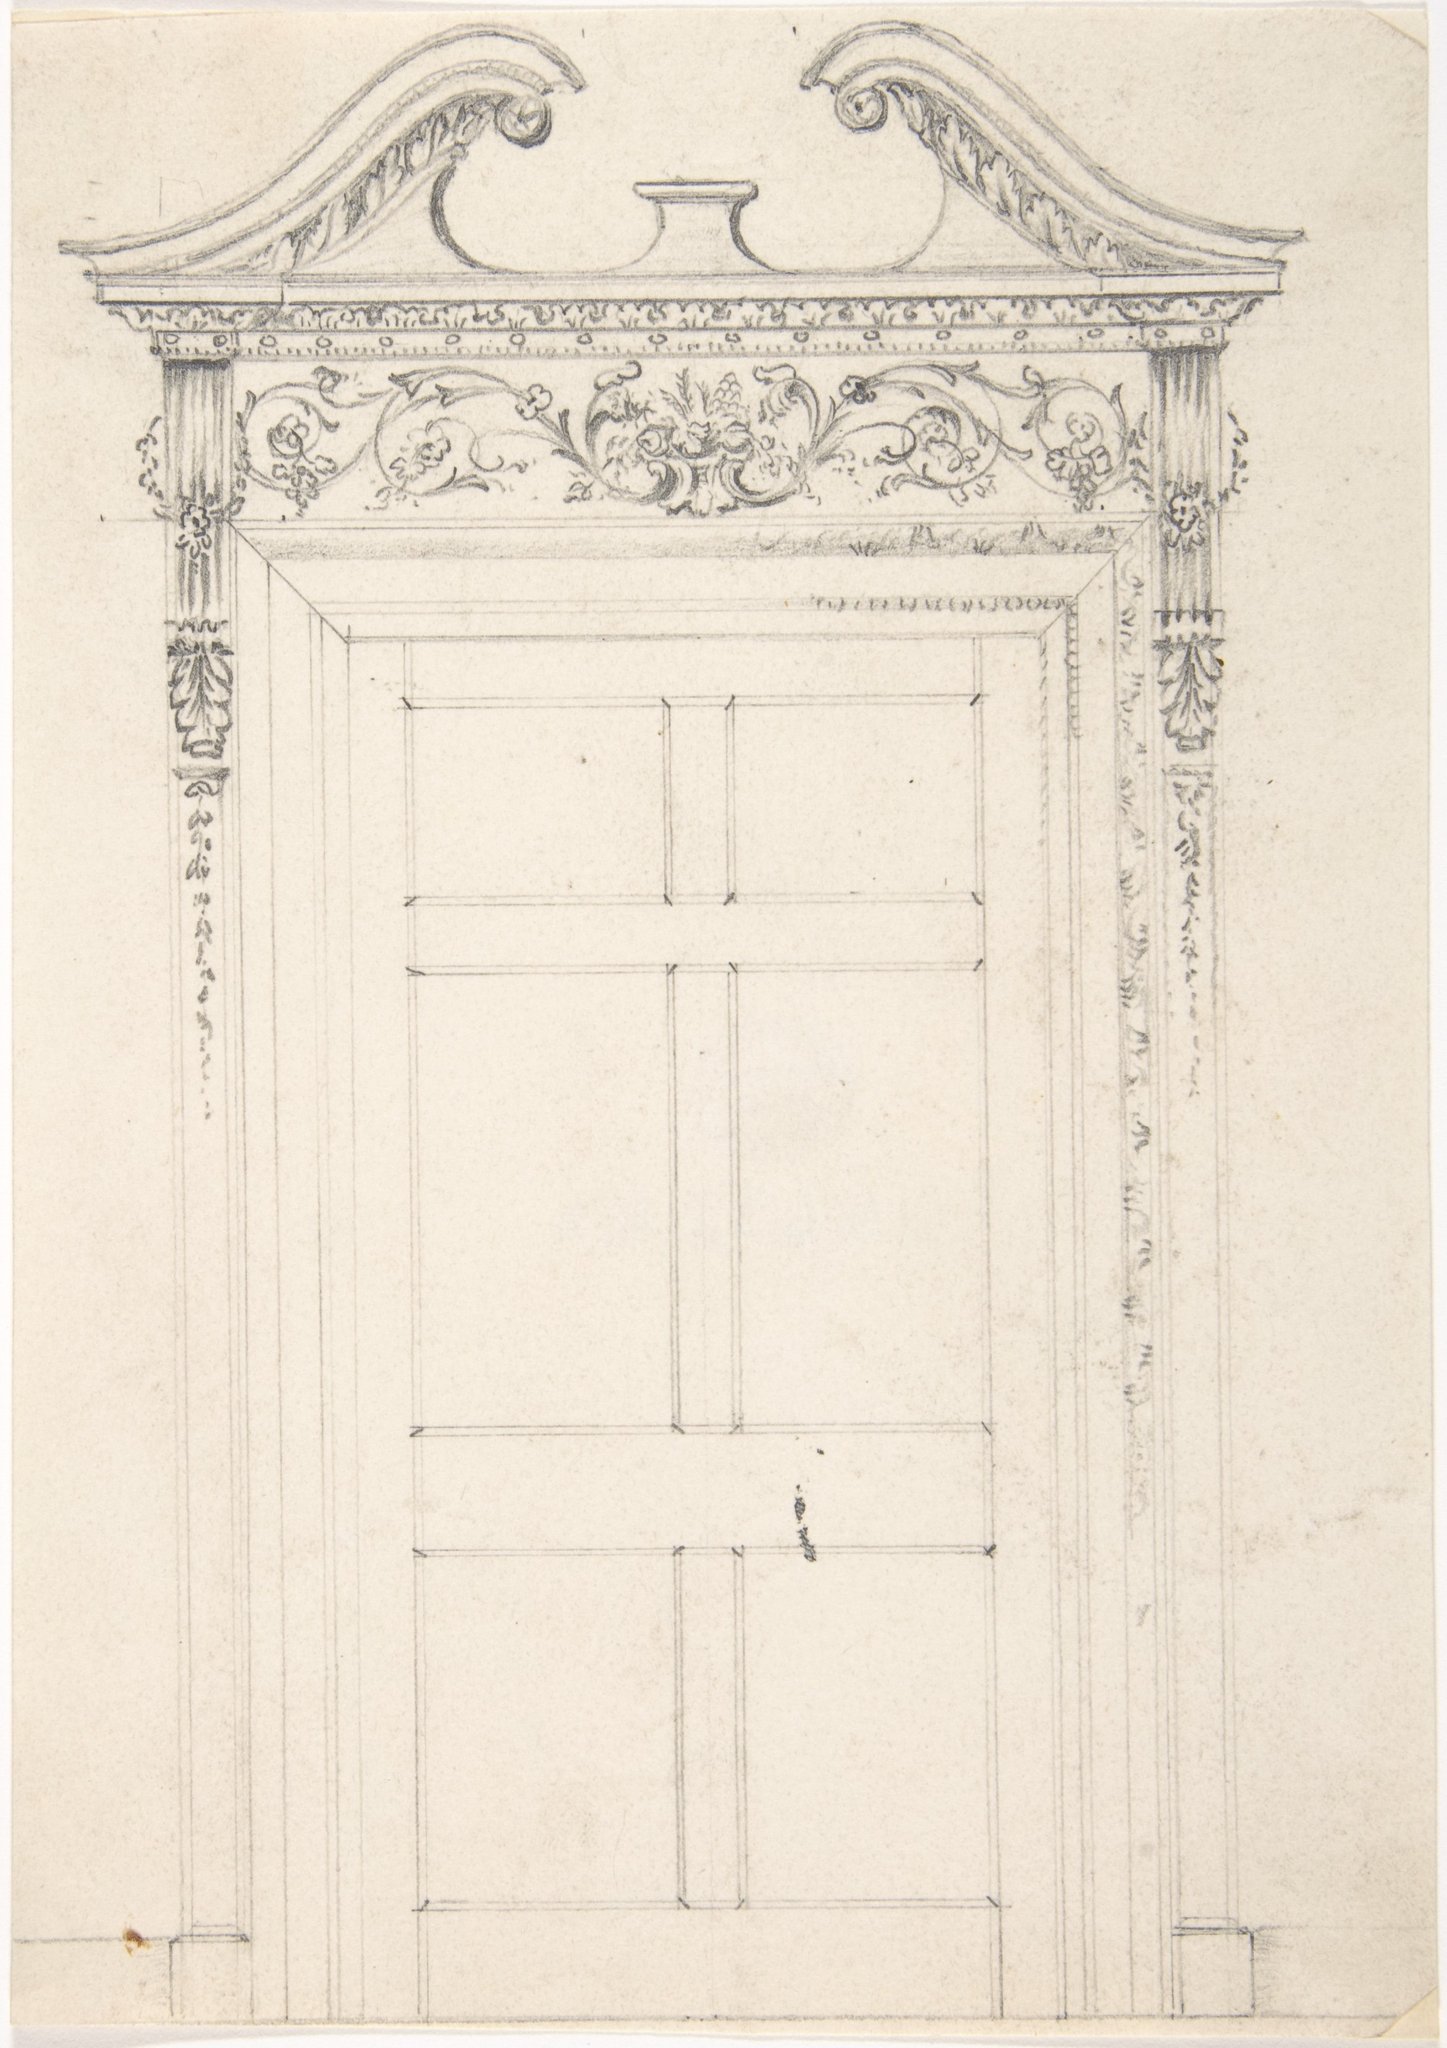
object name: drawing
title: Design for a Doorway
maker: anonymous, british, 19th century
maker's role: artist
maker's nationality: british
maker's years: 1800-1900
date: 1801-1850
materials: graphite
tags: doors,ornament